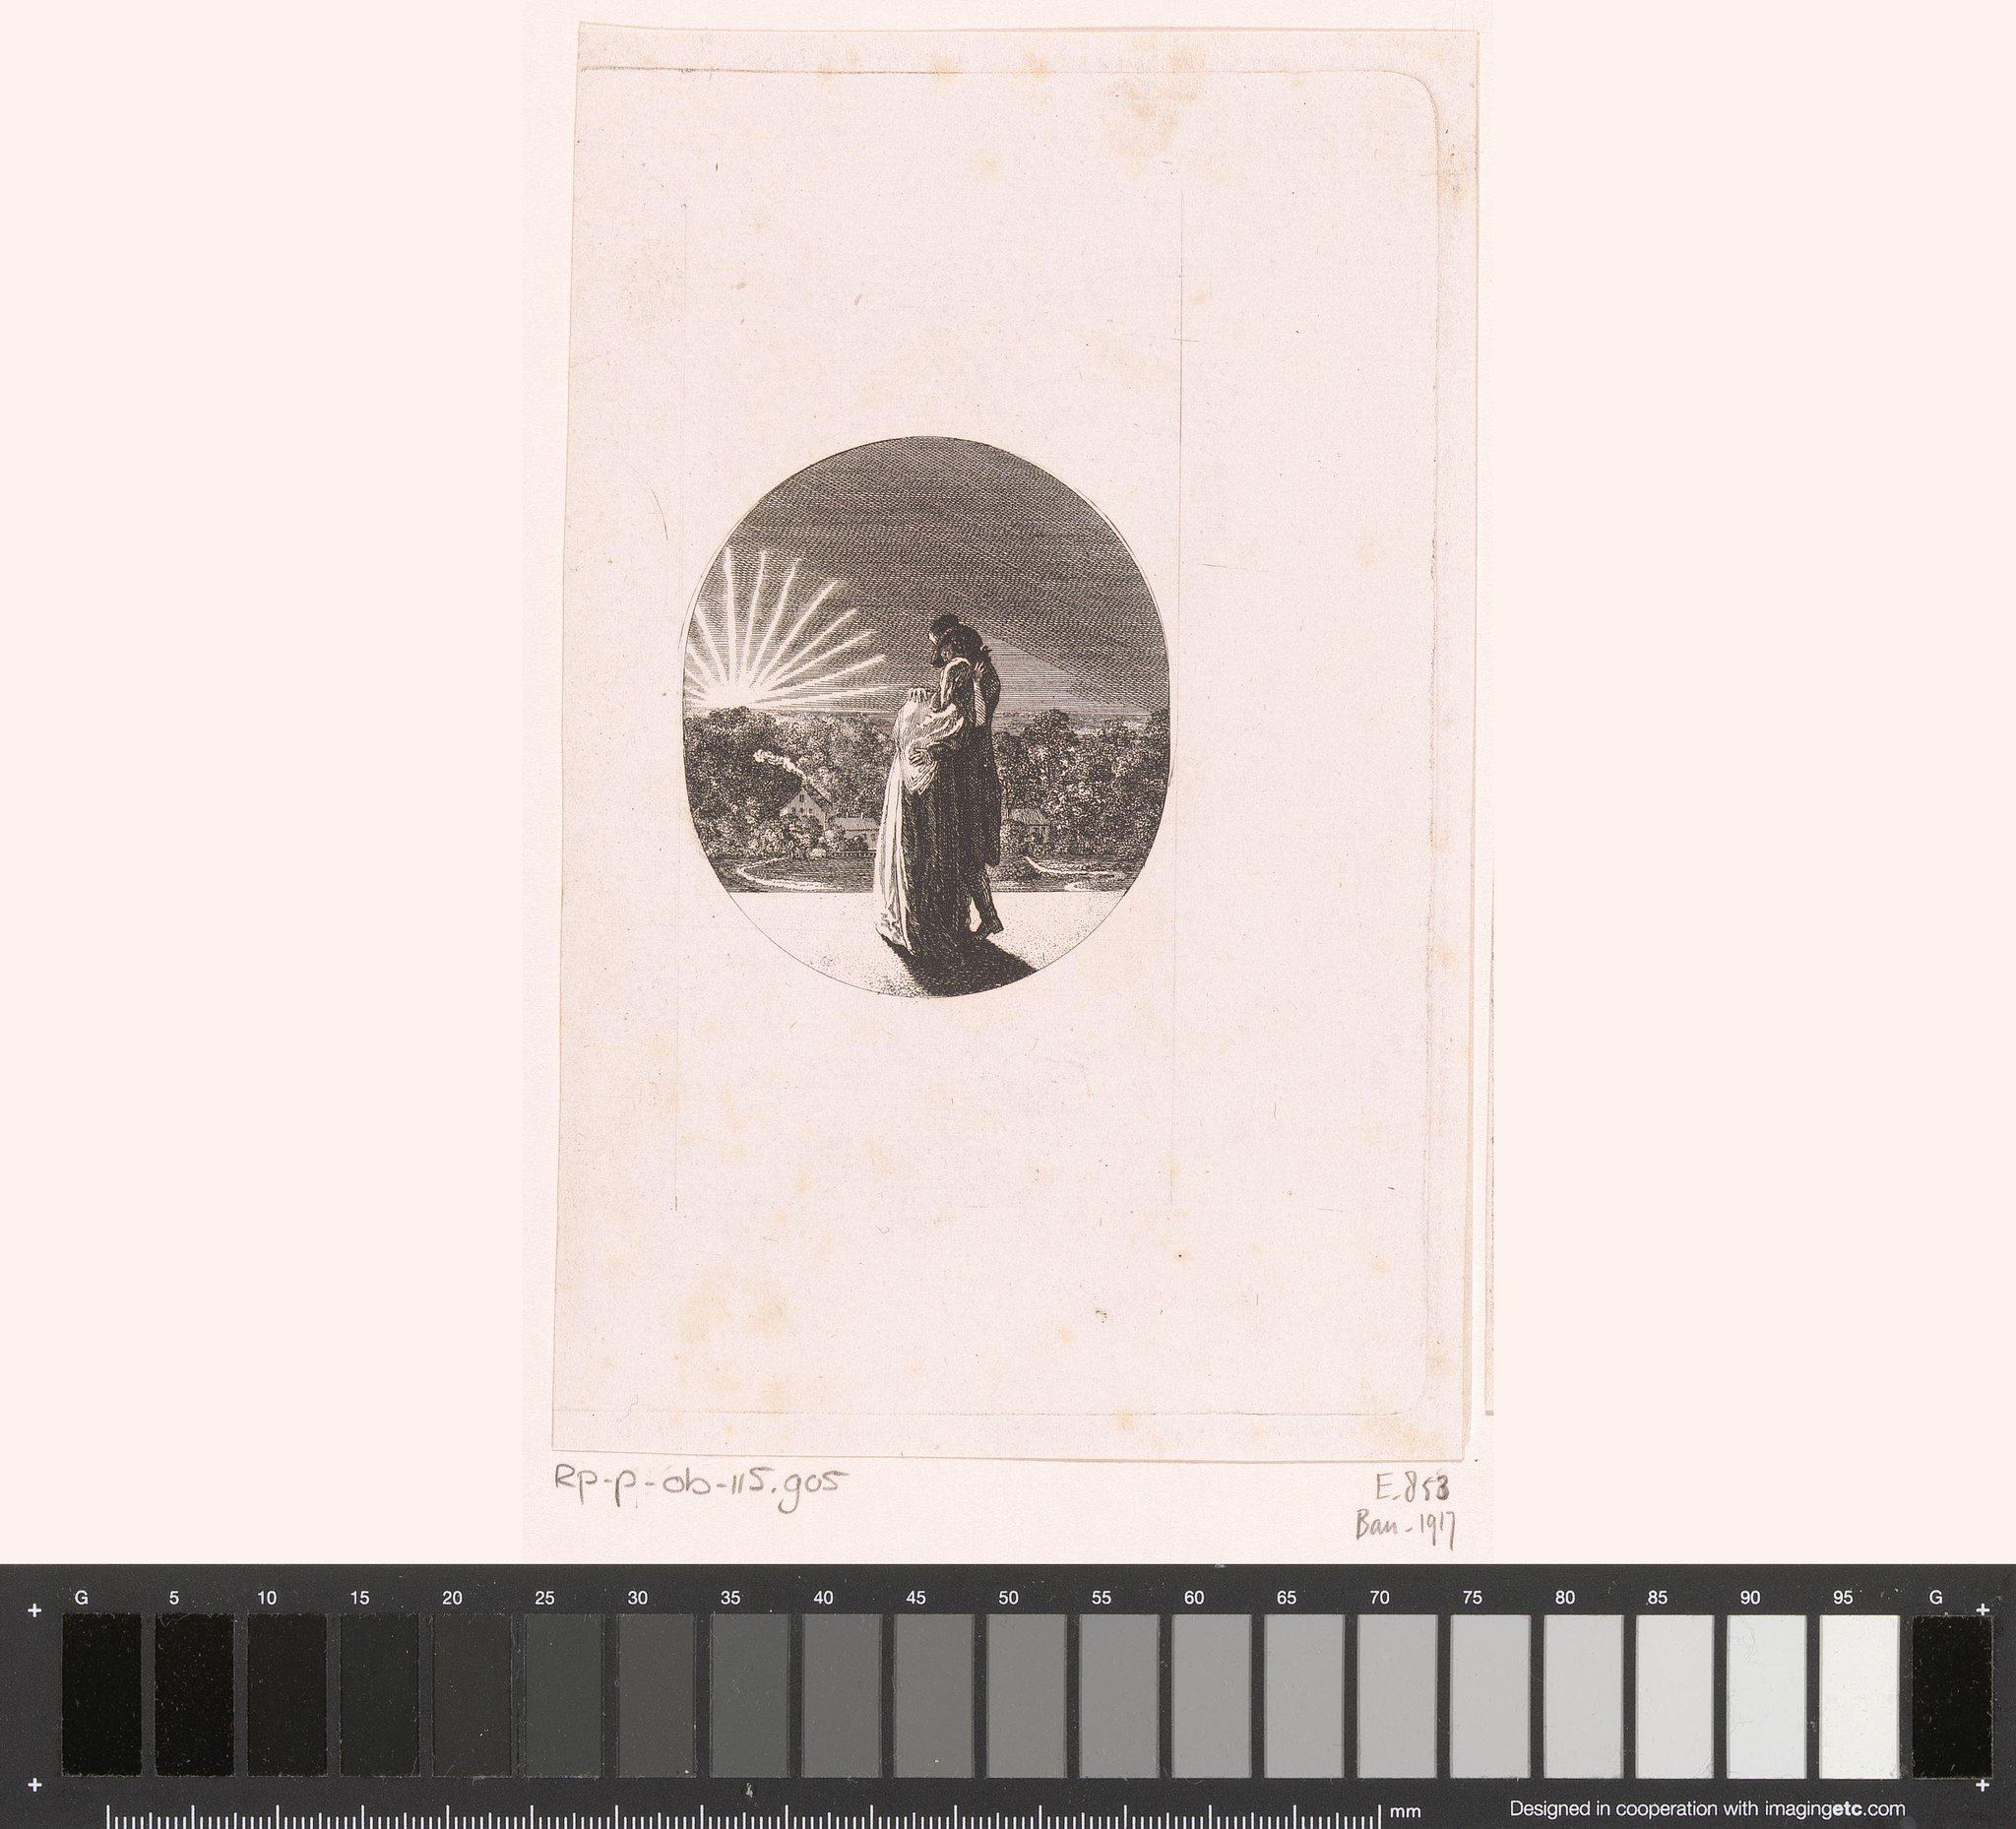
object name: print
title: Julchen omhelst haar vader bij zonsondergang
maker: daniel nikolaus chodowiecki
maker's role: draughtsman, print maker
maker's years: 1726-1801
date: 1797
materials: paper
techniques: etching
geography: berlin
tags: landscapes, (lovers) embracing each other, 'symplegma', sunset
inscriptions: collector's mark: Lugt 2228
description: Latere staat gebruikt voor: Unger, Friederike Helene. Julchen Grünthal. 2 dln. Berlijn: Johann Friedrich Unger, 1798, dl. 1.